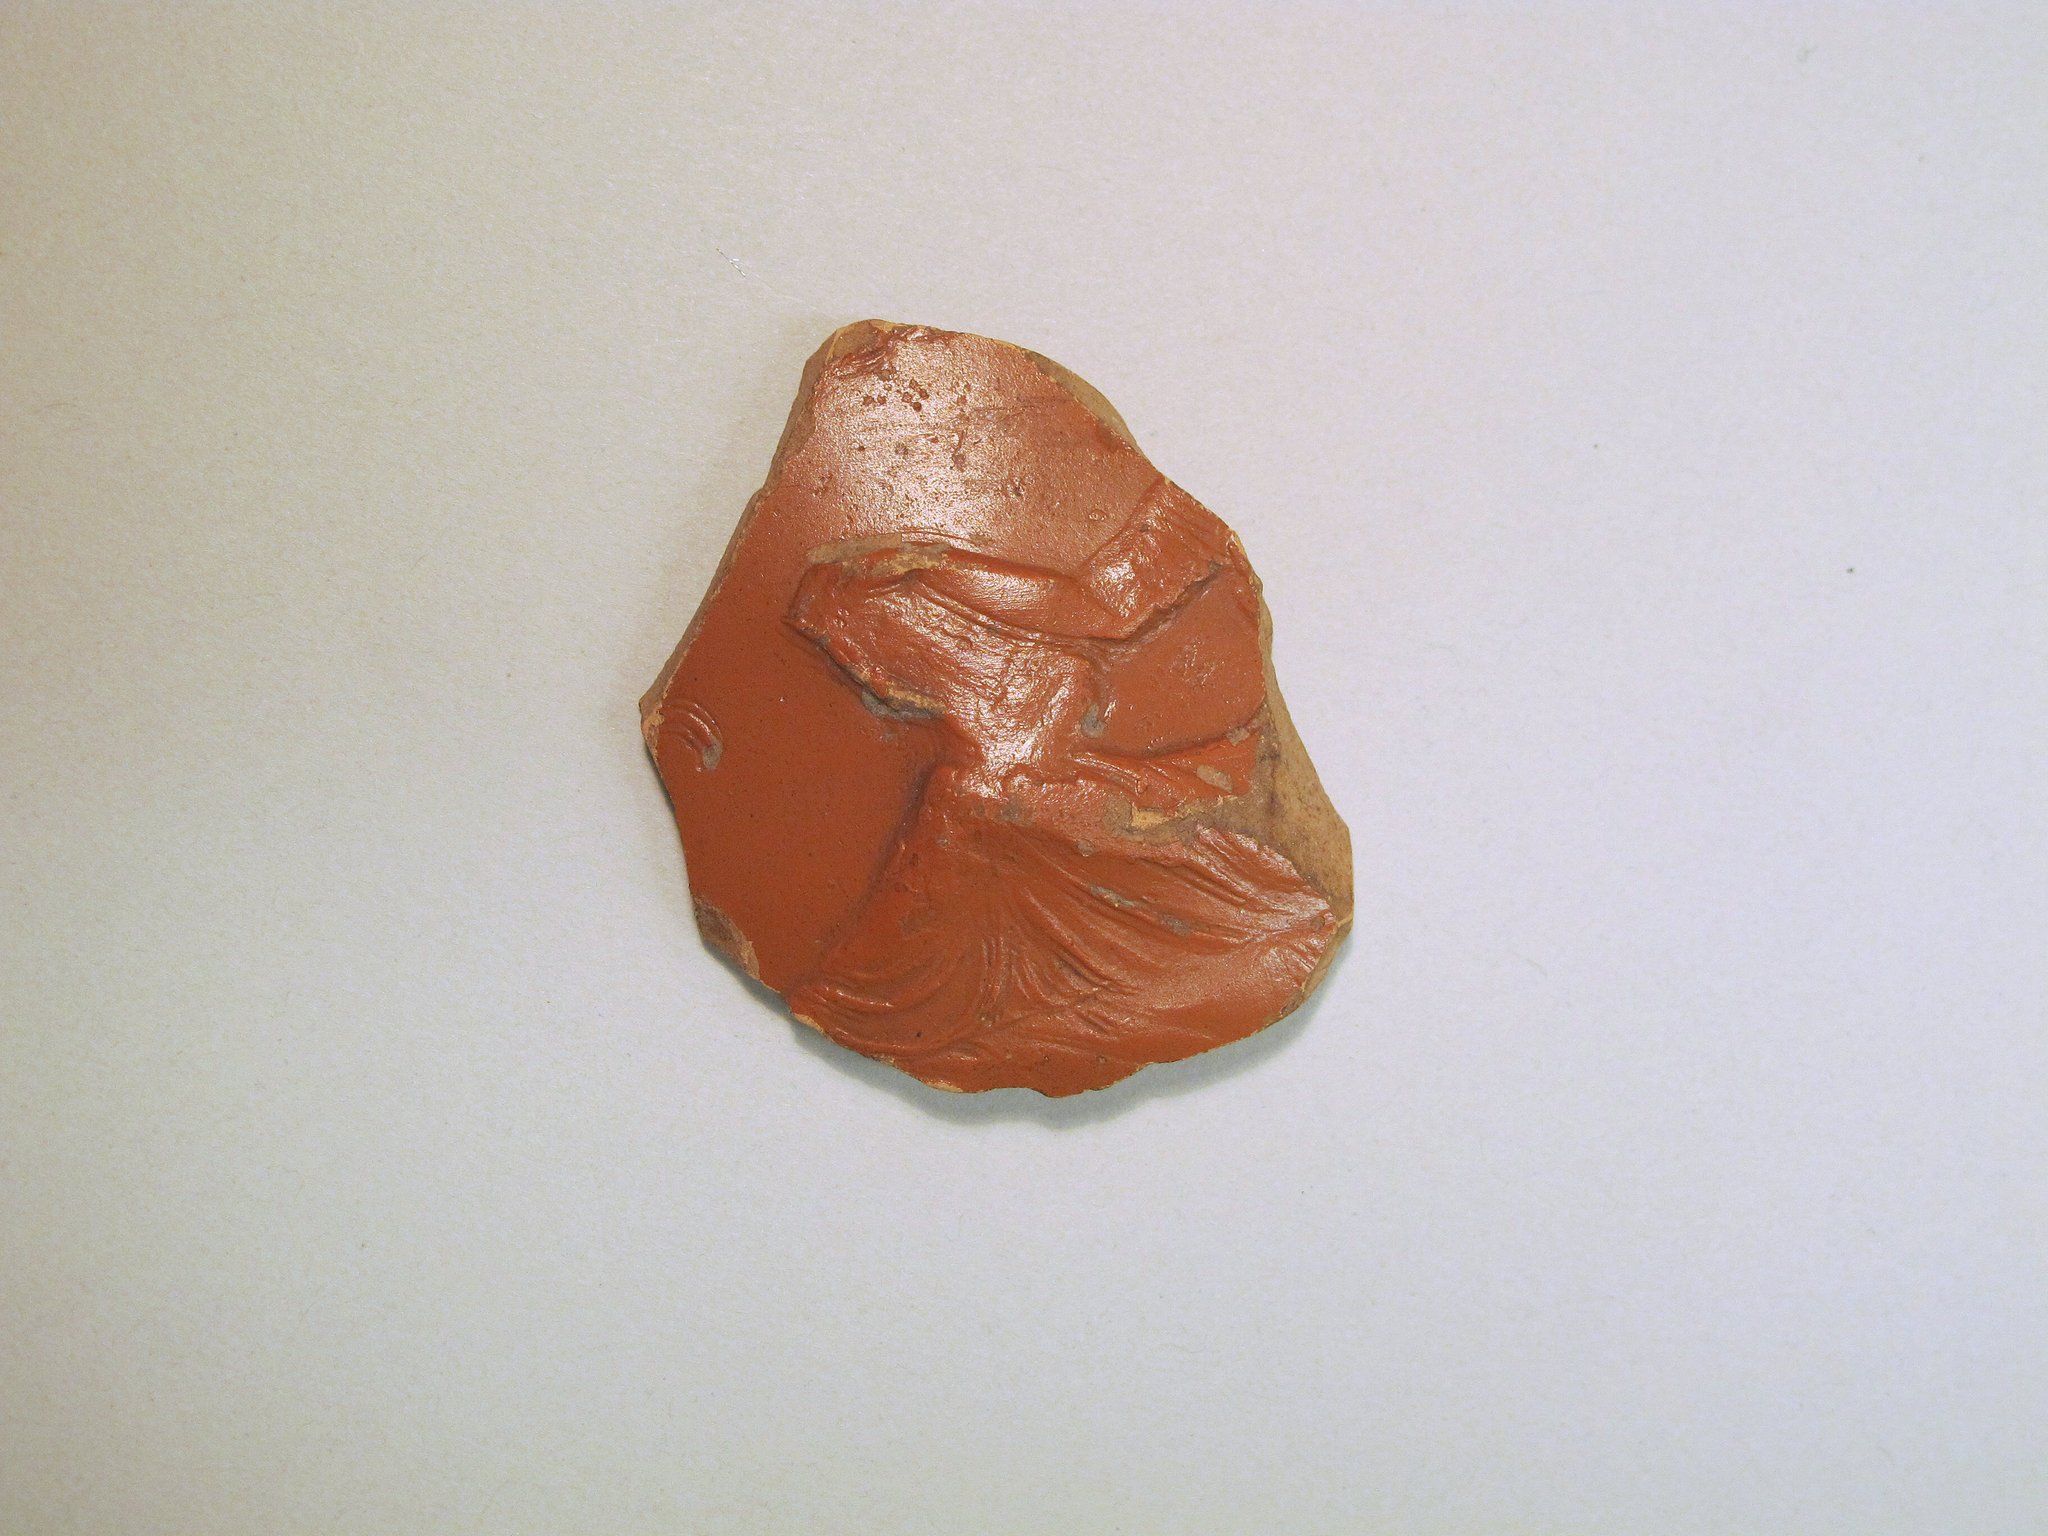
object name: vase fragment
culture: roman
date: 100 BCE-100 CE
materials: terracotta